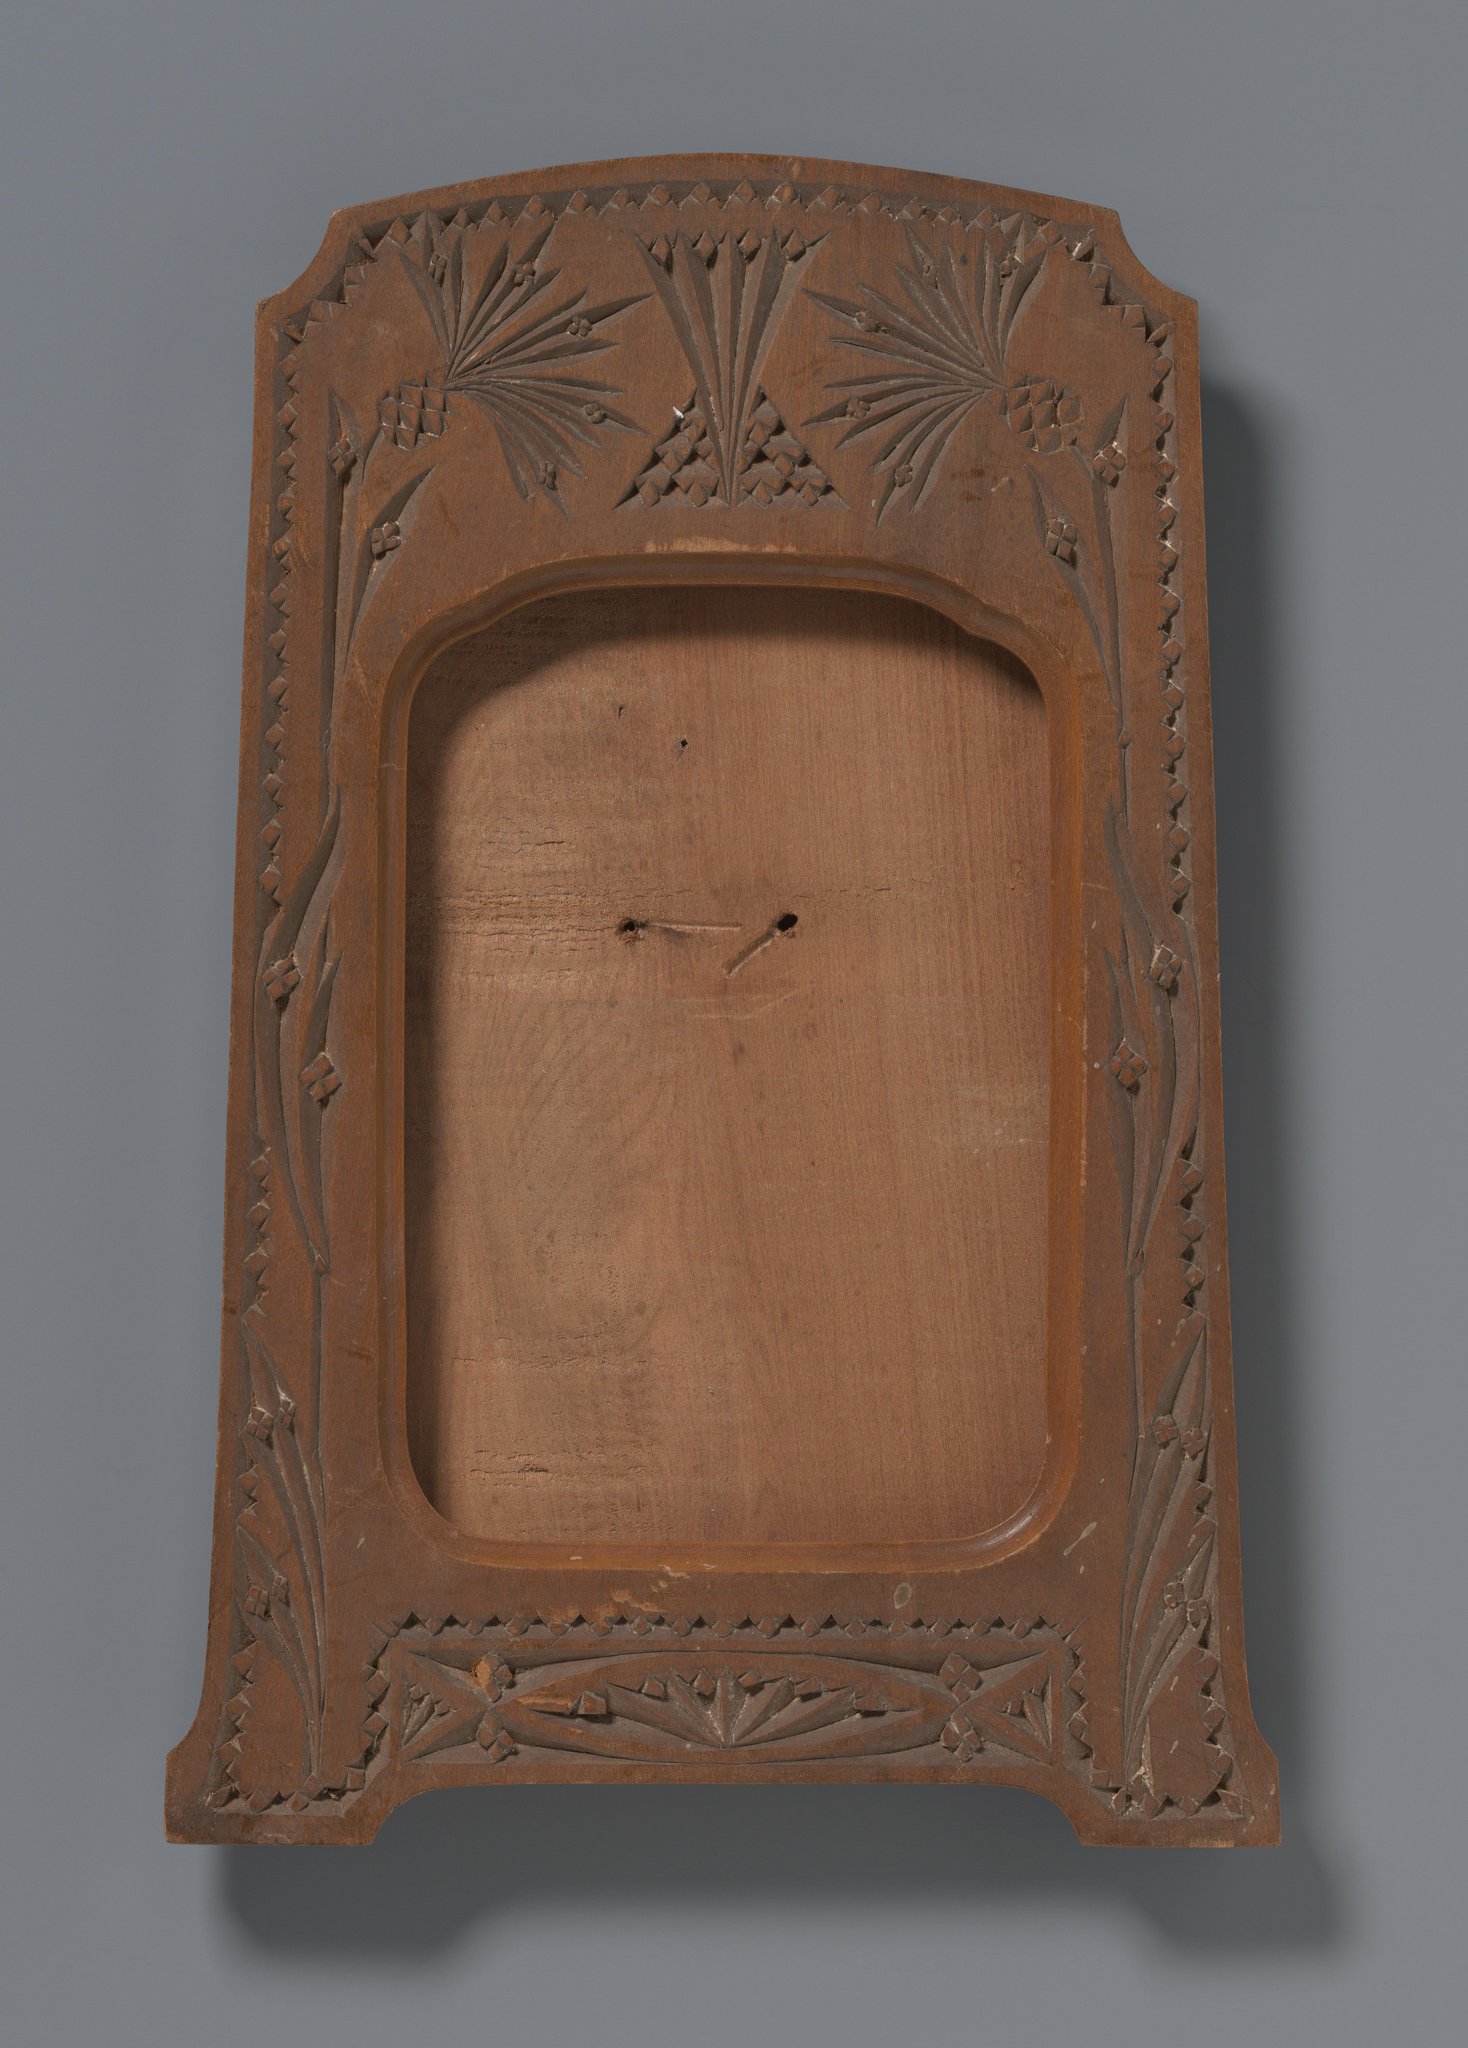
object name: frame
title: Lijst met houtsnijwerk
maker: Anonymous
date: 1880-1930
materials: wood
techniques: cutting